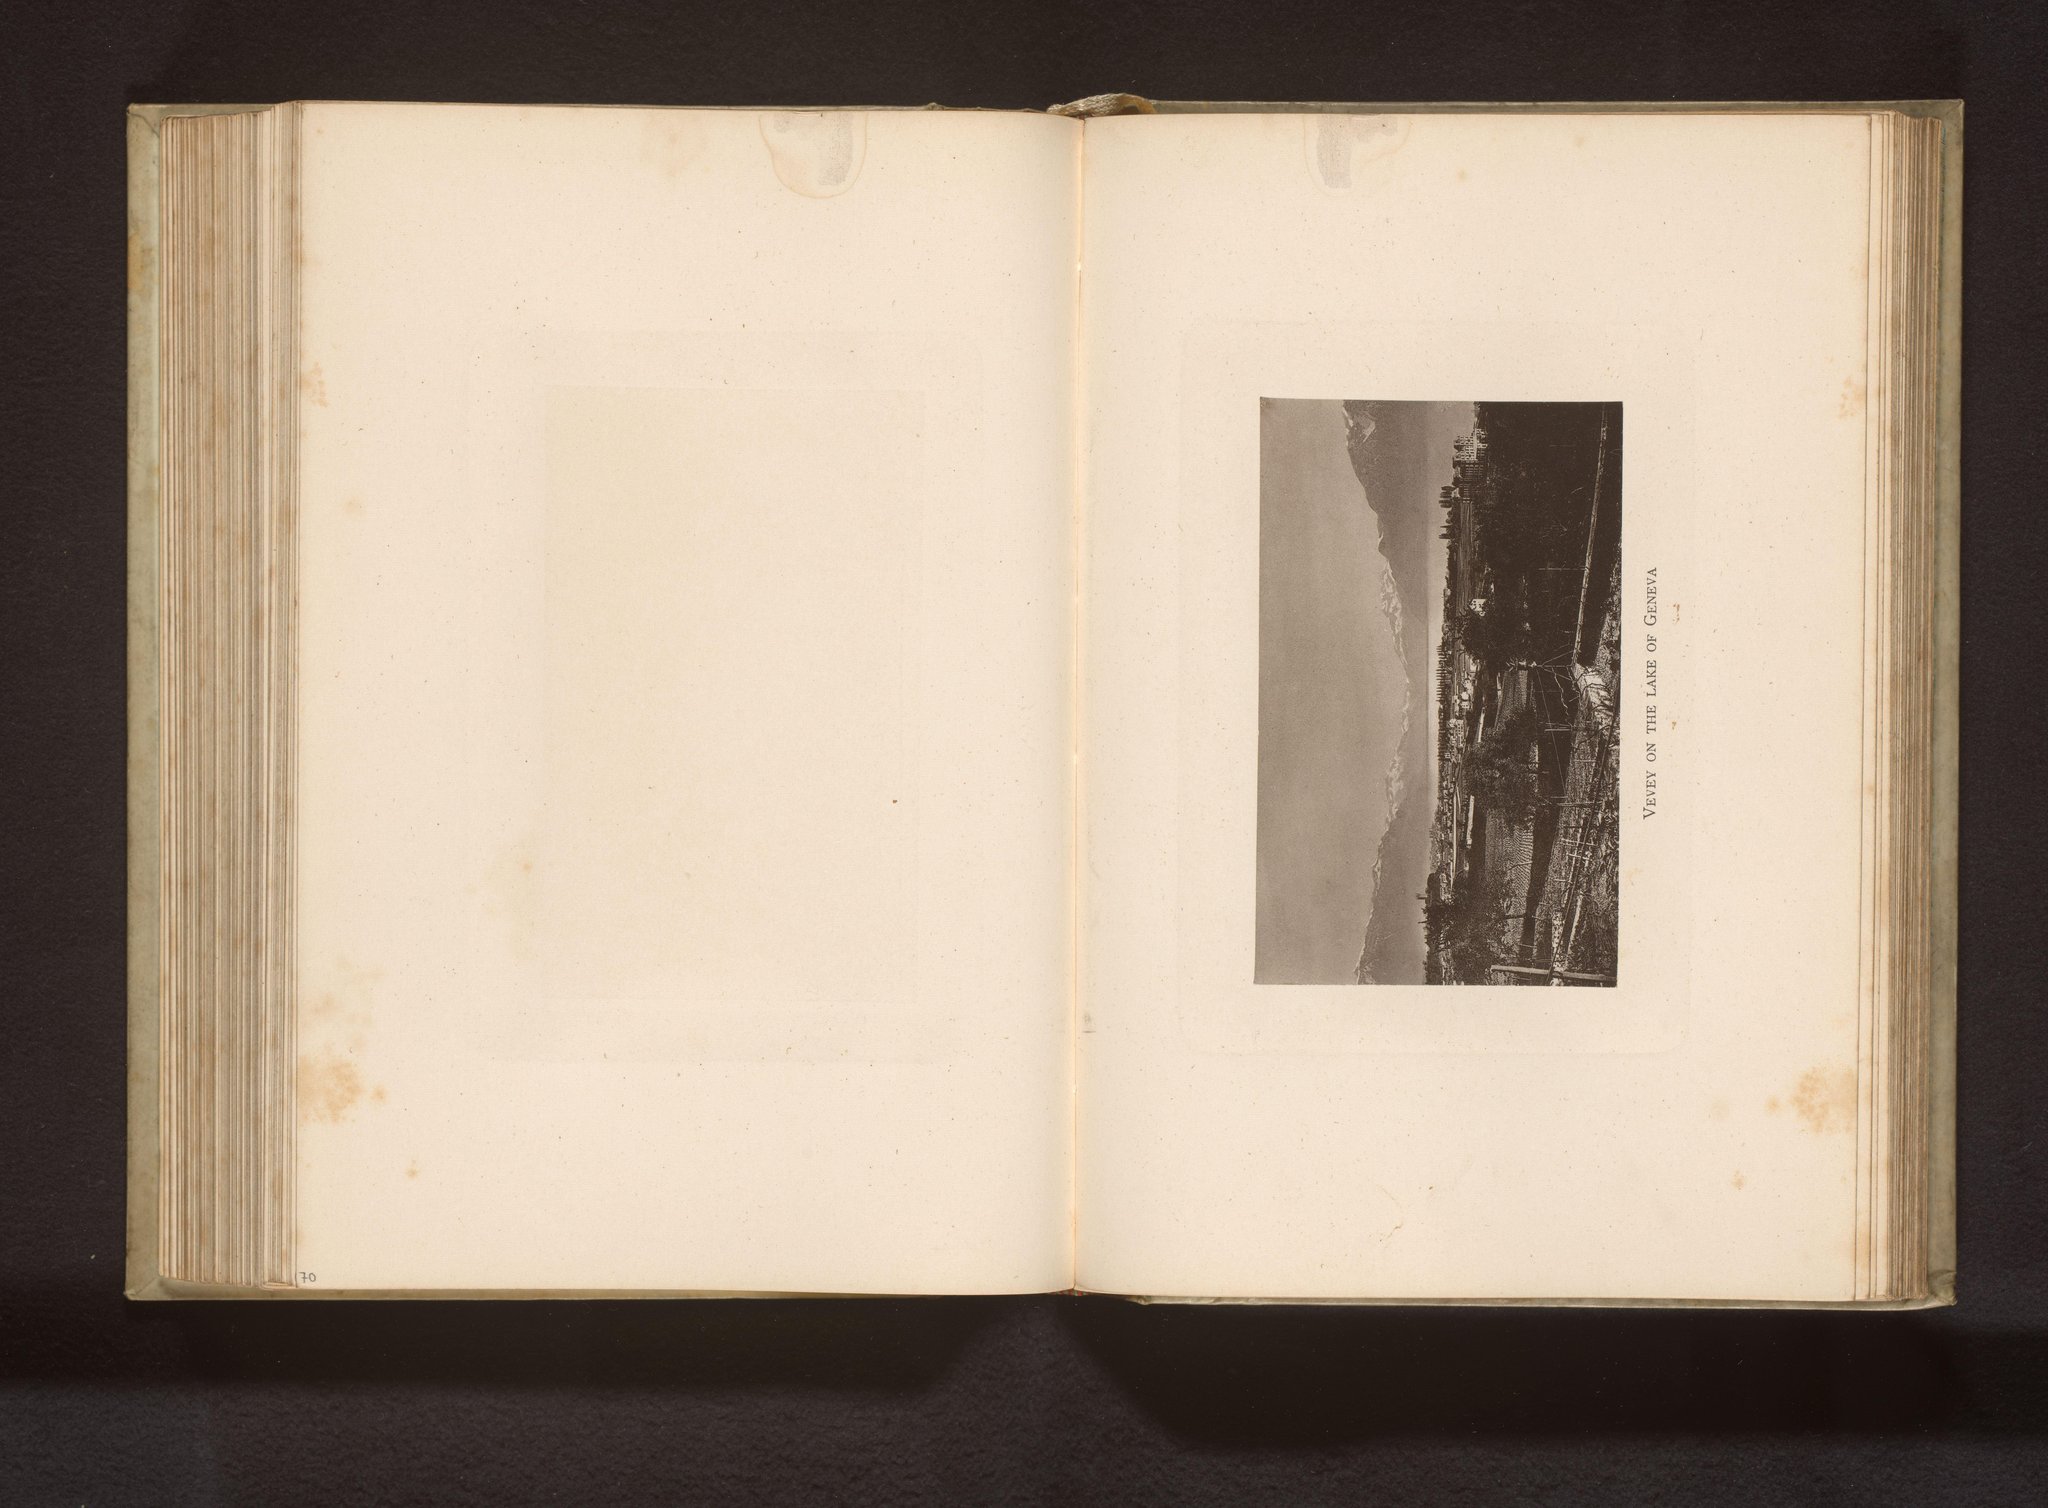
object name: photomechanical print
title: Vevy on the lake of Geneva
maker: Anonymous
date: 1874-1884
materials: paper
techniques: photograph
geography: vaud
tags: lake, prospect of city, town panorama, silhouette of city, mountains